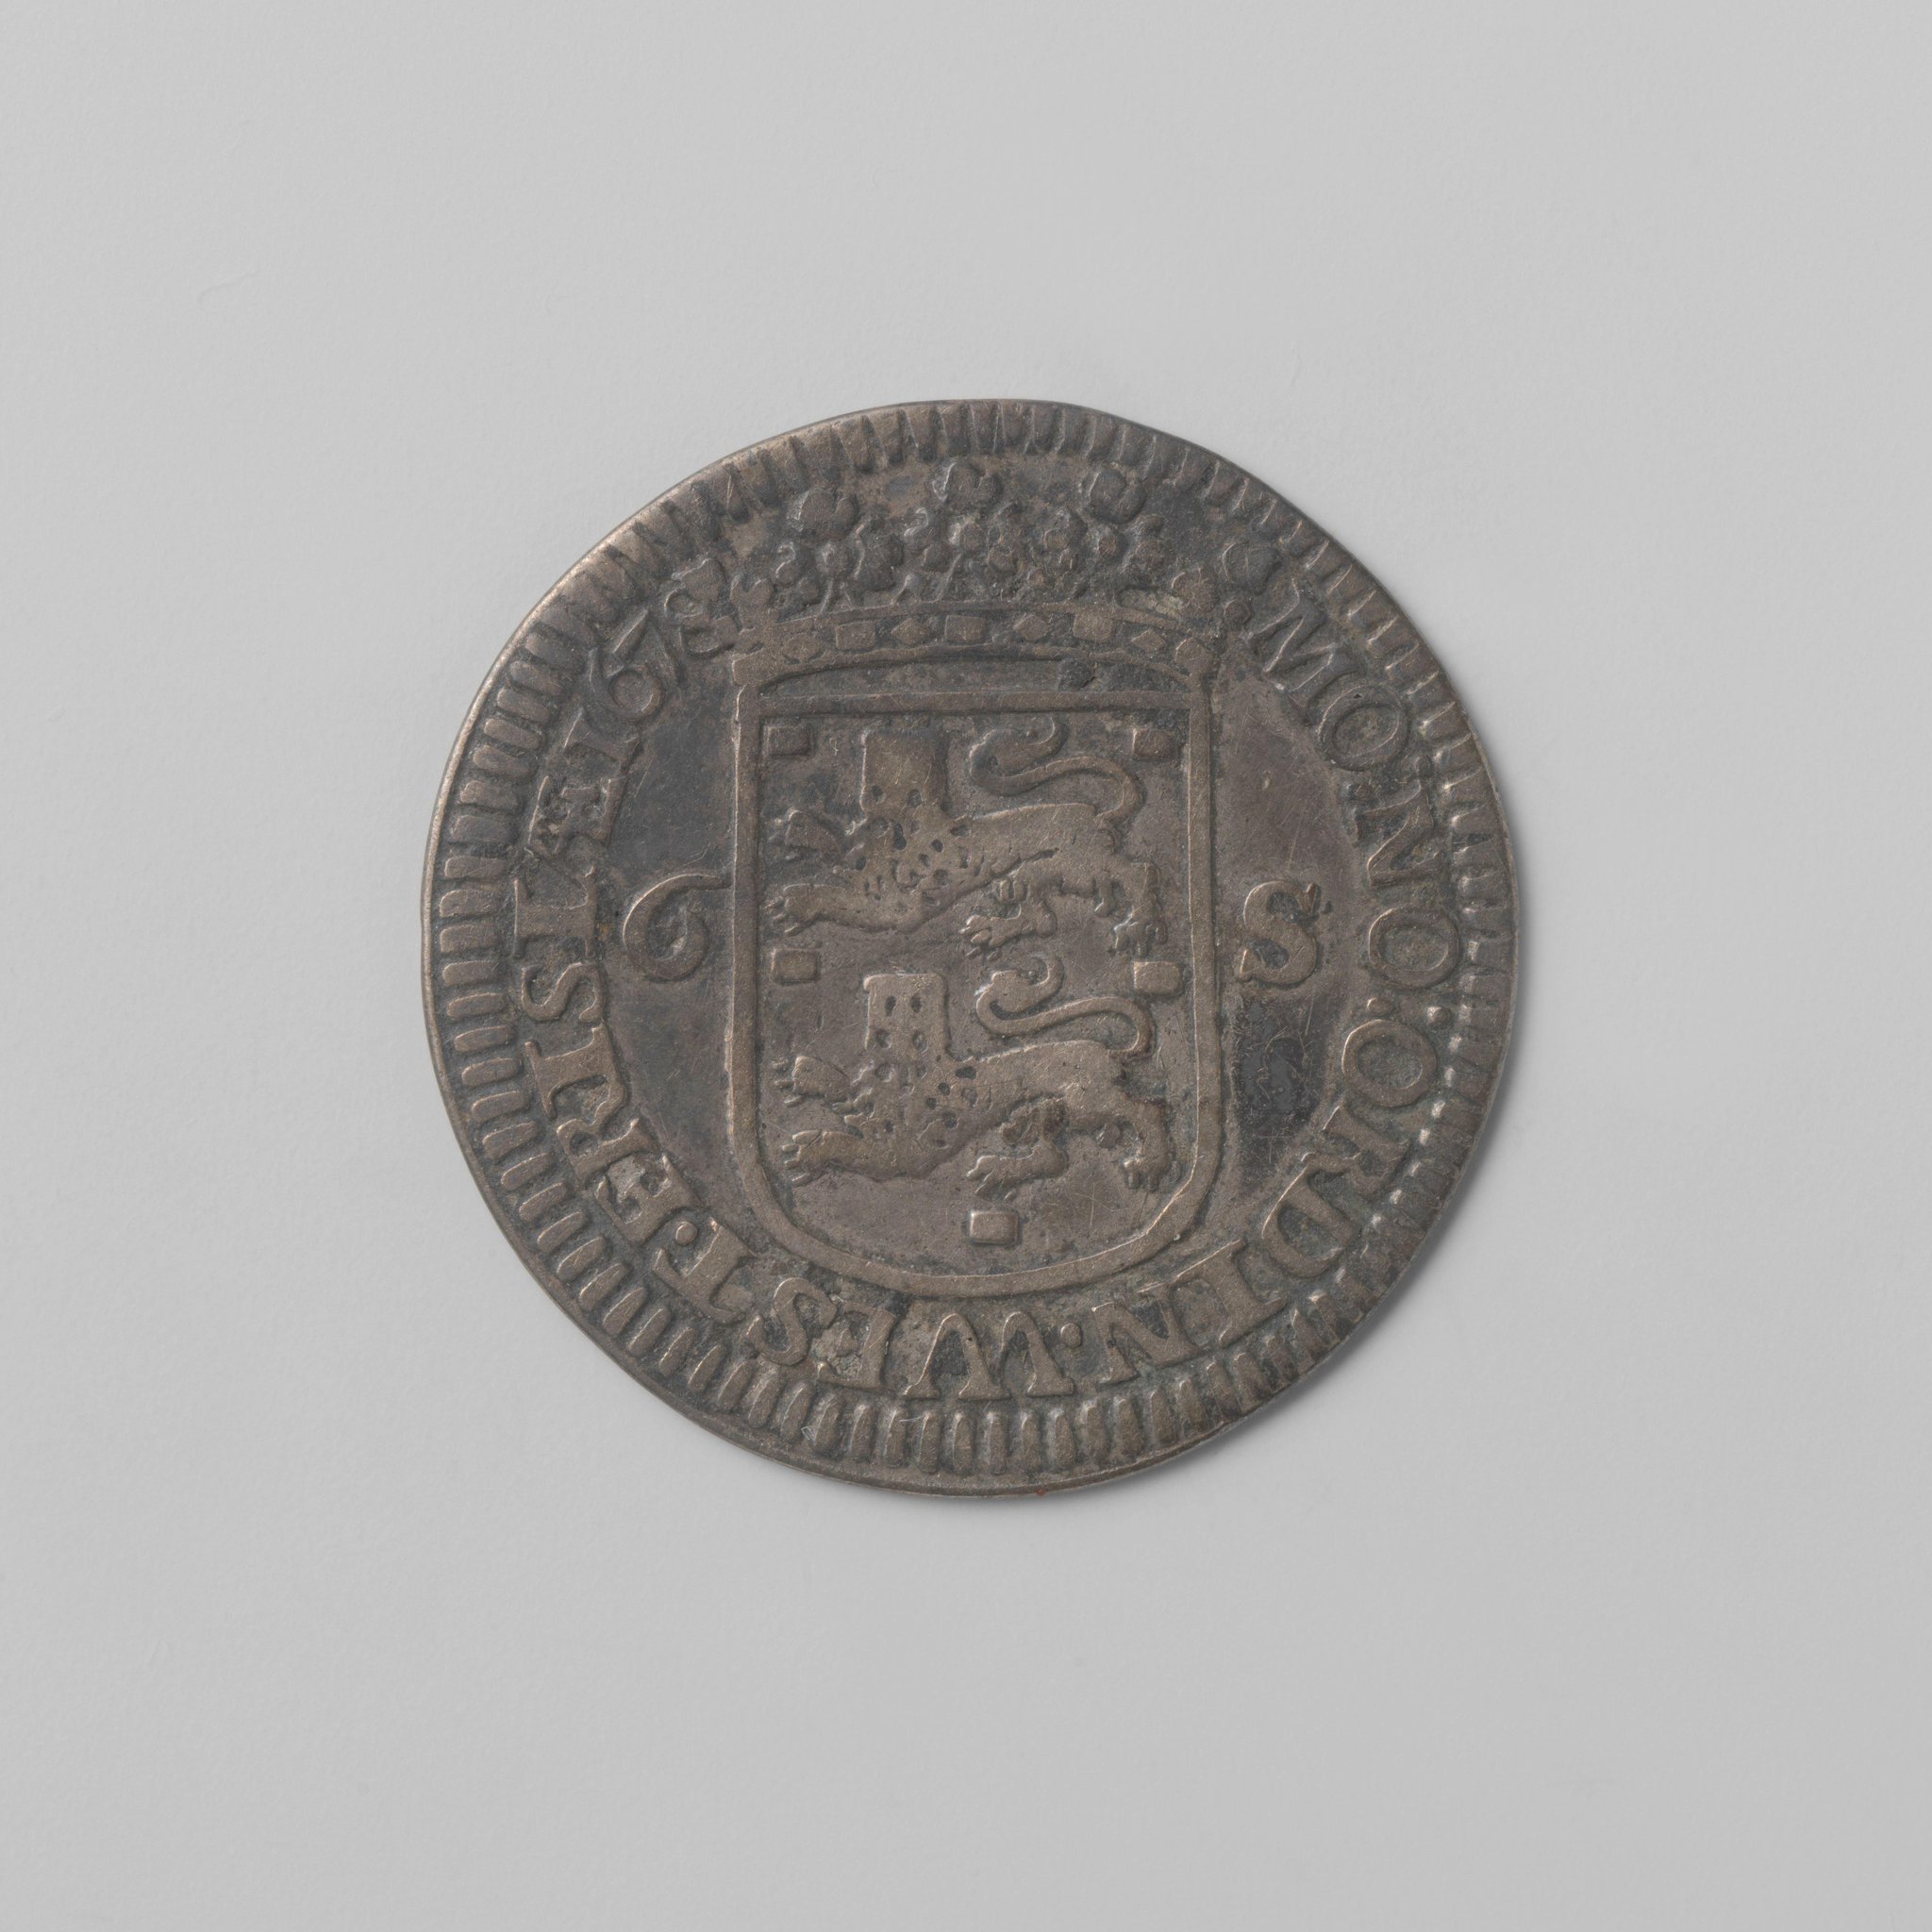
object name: coin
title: West-Friesland, scheepjesschelling, 1678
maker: dirck bosch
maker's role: mintmaster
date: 1678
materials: silver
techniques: striking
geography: enkhuizen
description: Voorzijde: tussen waarde-aanduiding 6 S gekroond wapenschild van West-Friesland. Keerzijde: schip met zeilen naar rechts.